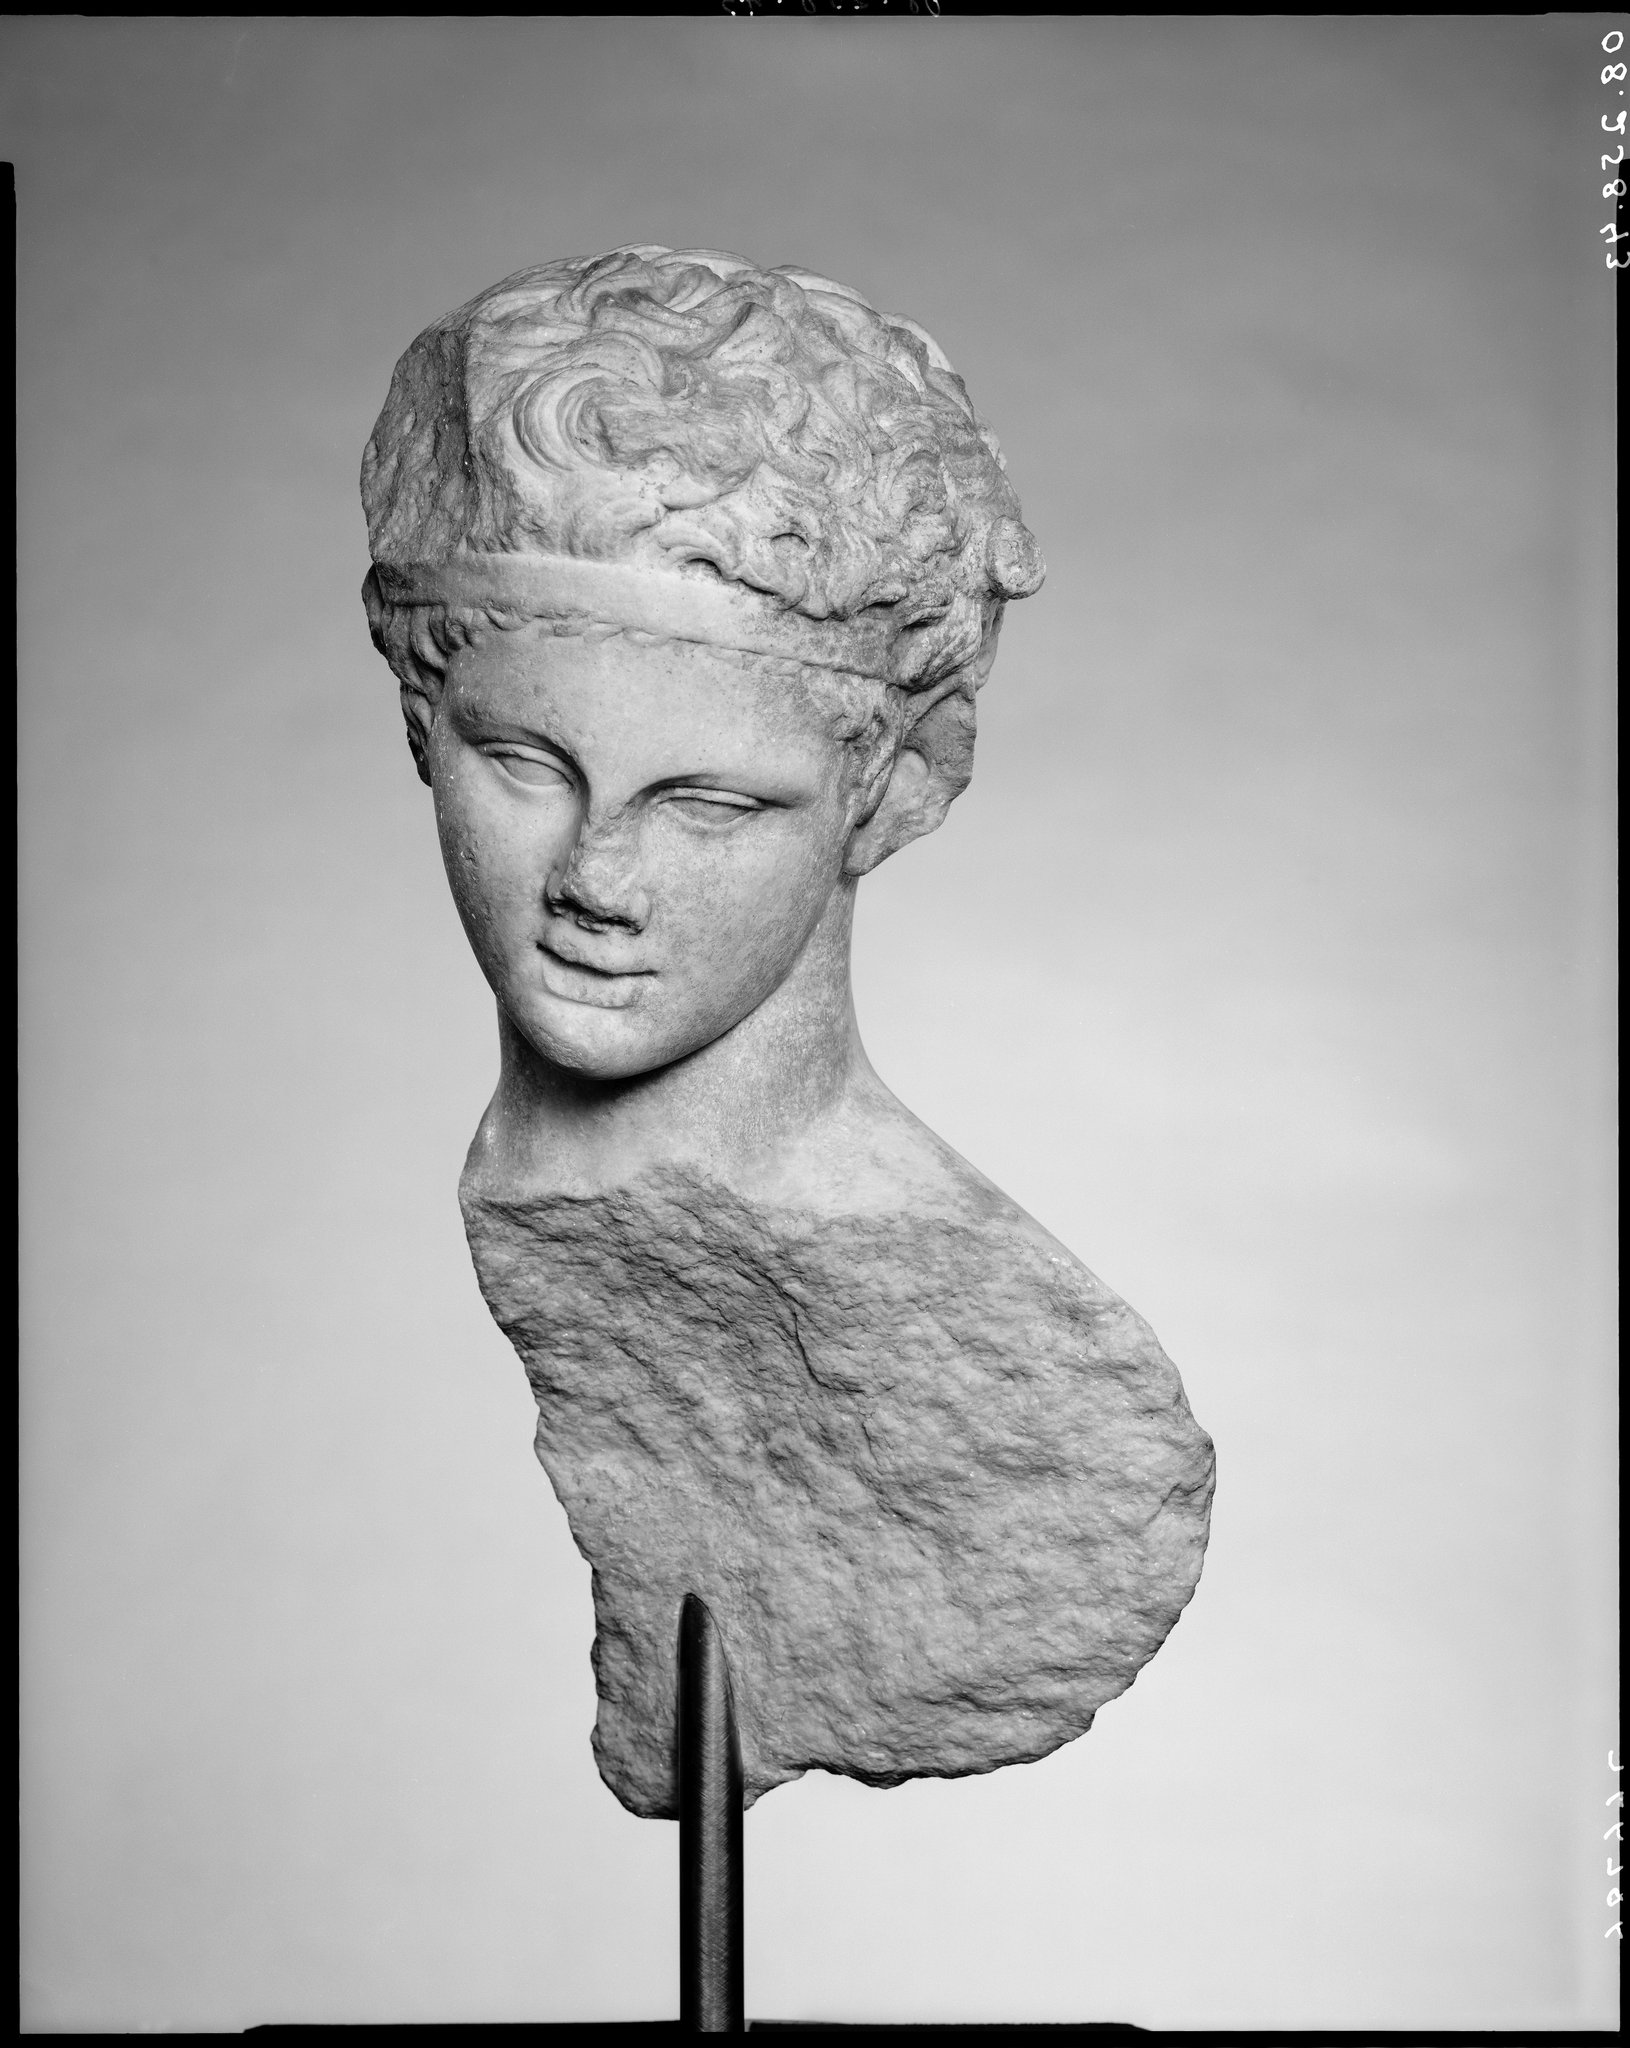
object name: statue of a satyr, fragment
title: Head and part of the back of a marble statue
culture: roman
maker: praxiteles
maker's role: artist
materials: marble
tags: heads